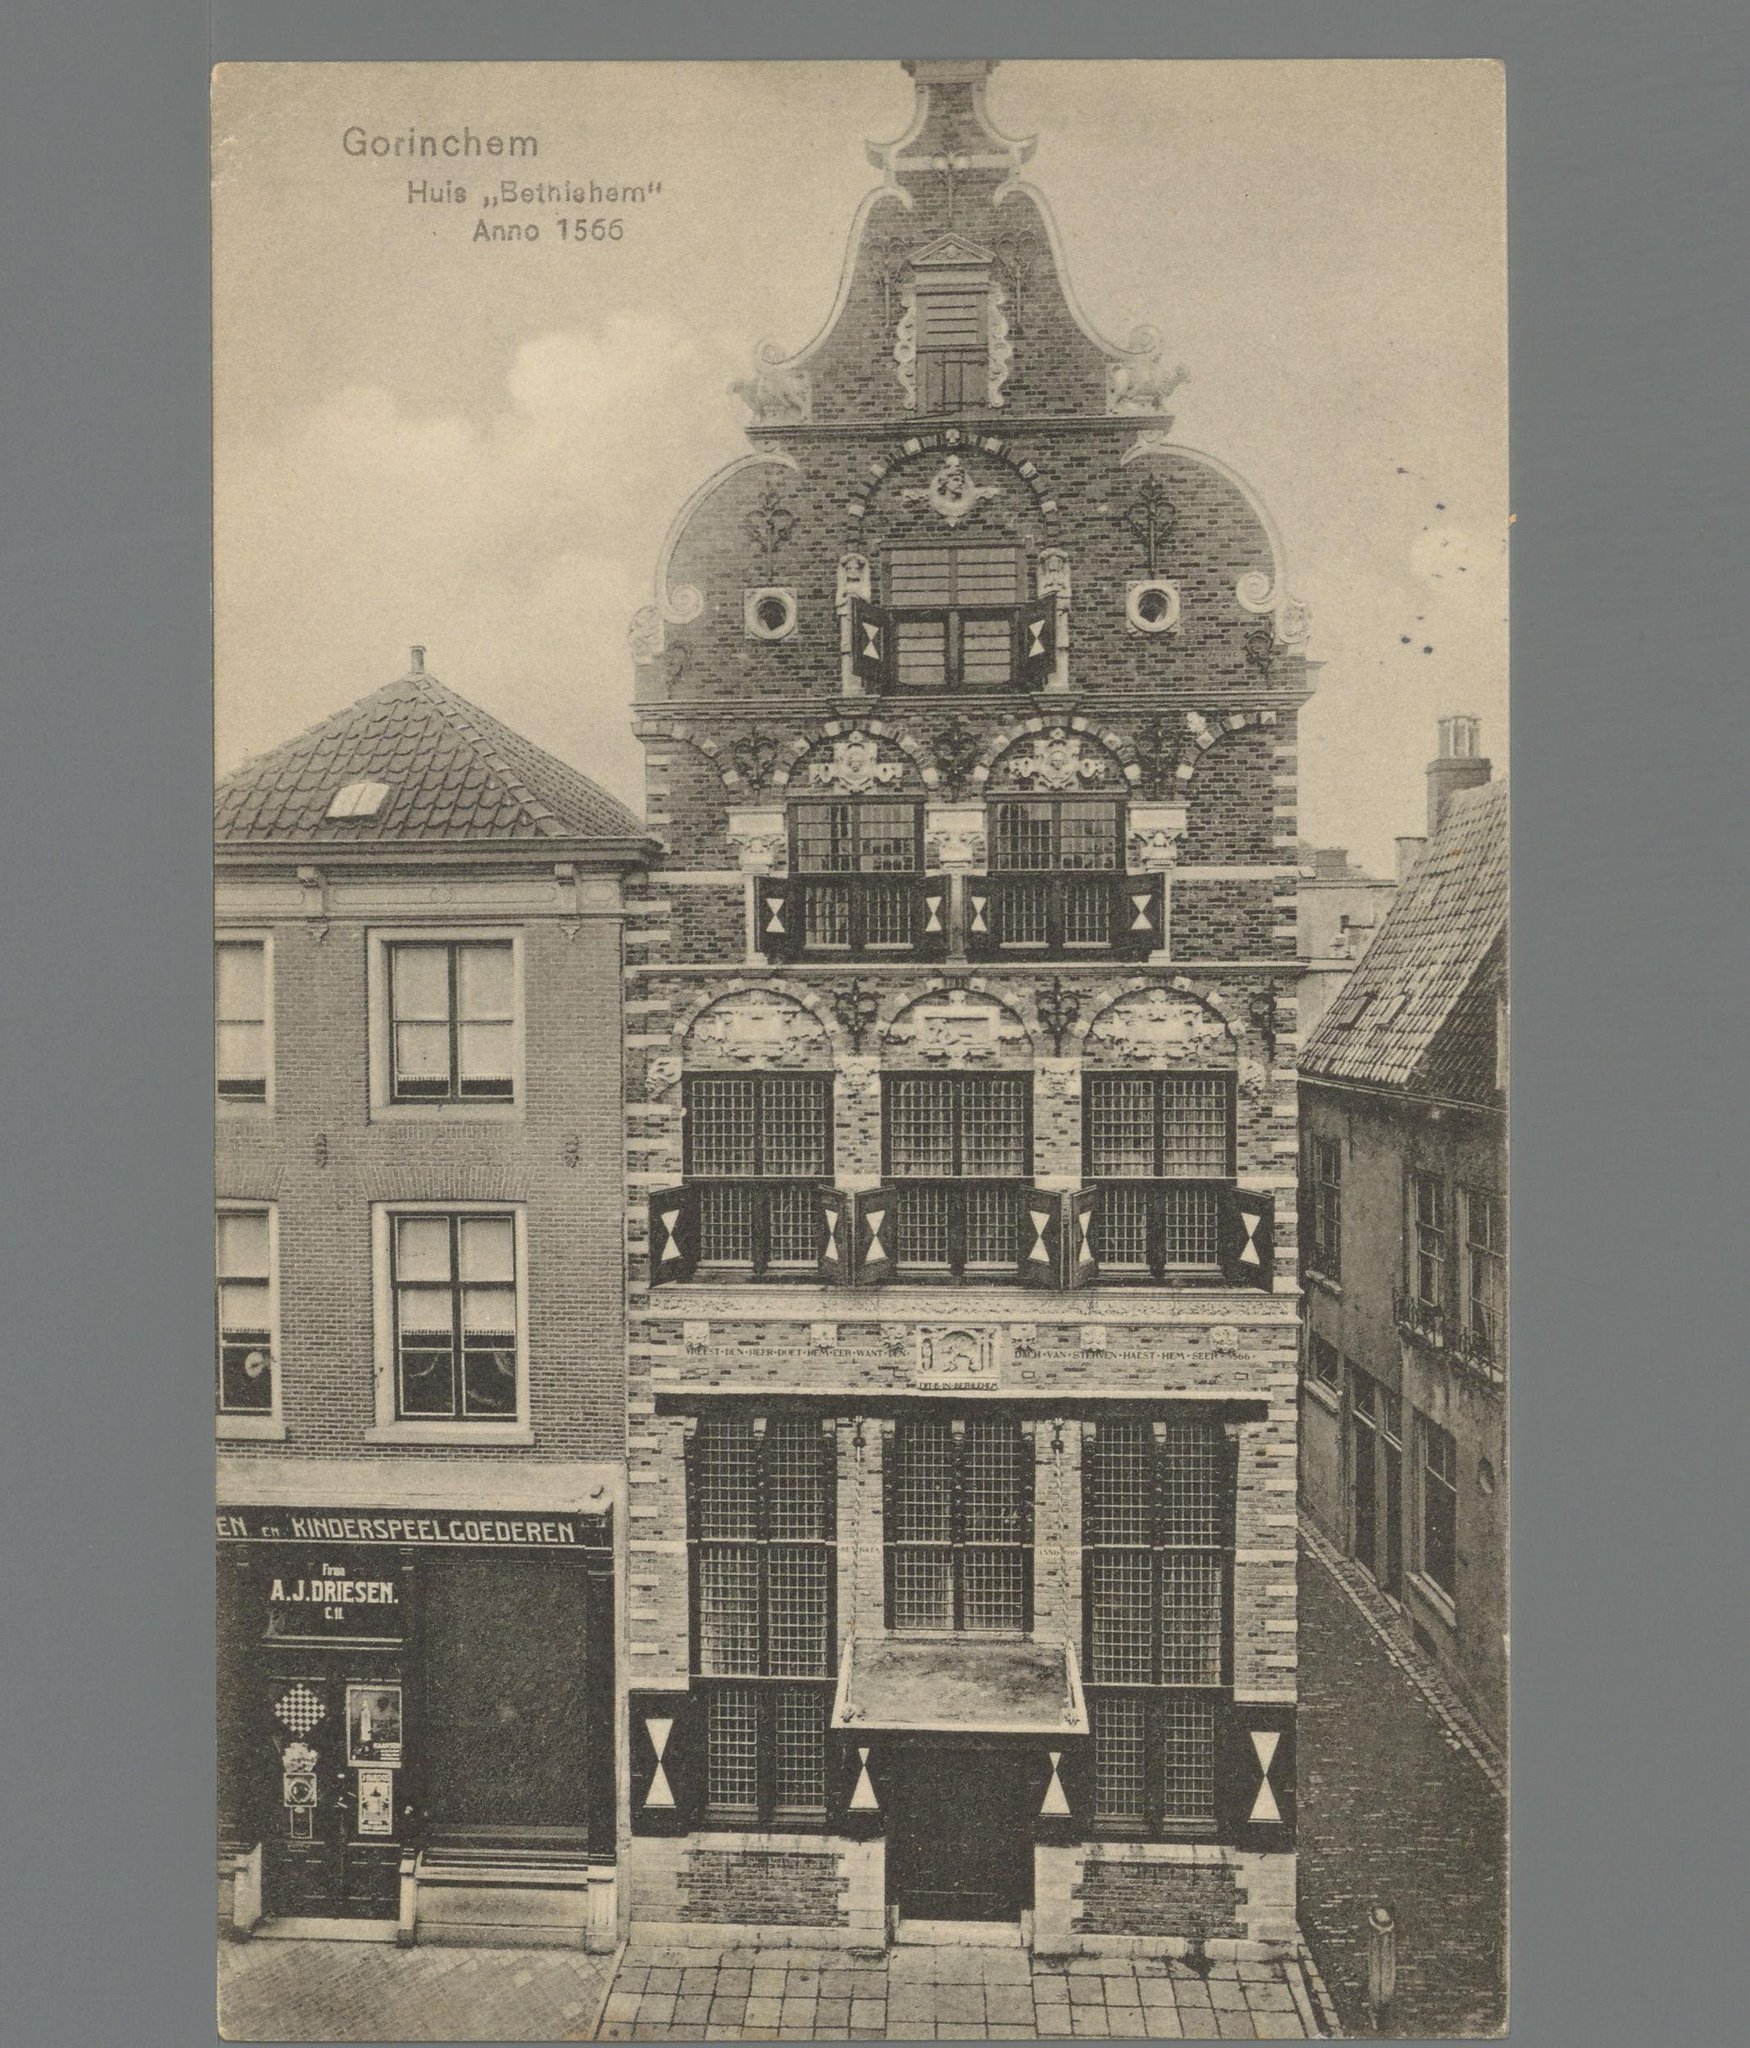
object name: photomechanical print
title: Gorinchem. Huis "Bethlehem". Anno 1566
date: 1911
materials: cardboard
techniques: photograph, writing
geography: gorinchem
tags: façade (of house or building)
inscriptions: postage stamp